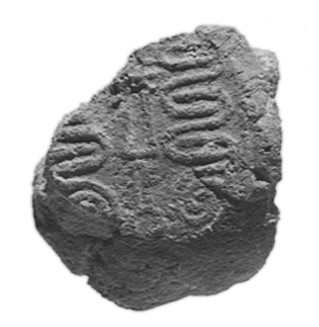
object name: sealing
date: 2030-1640 BCE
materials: clay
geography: egypt